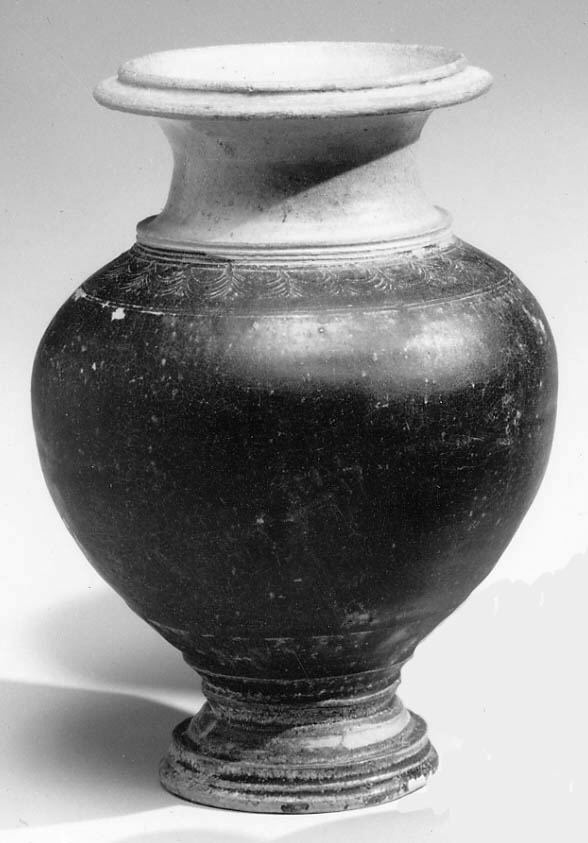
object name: footed urn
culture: thai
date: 1034-1200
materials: stoneware